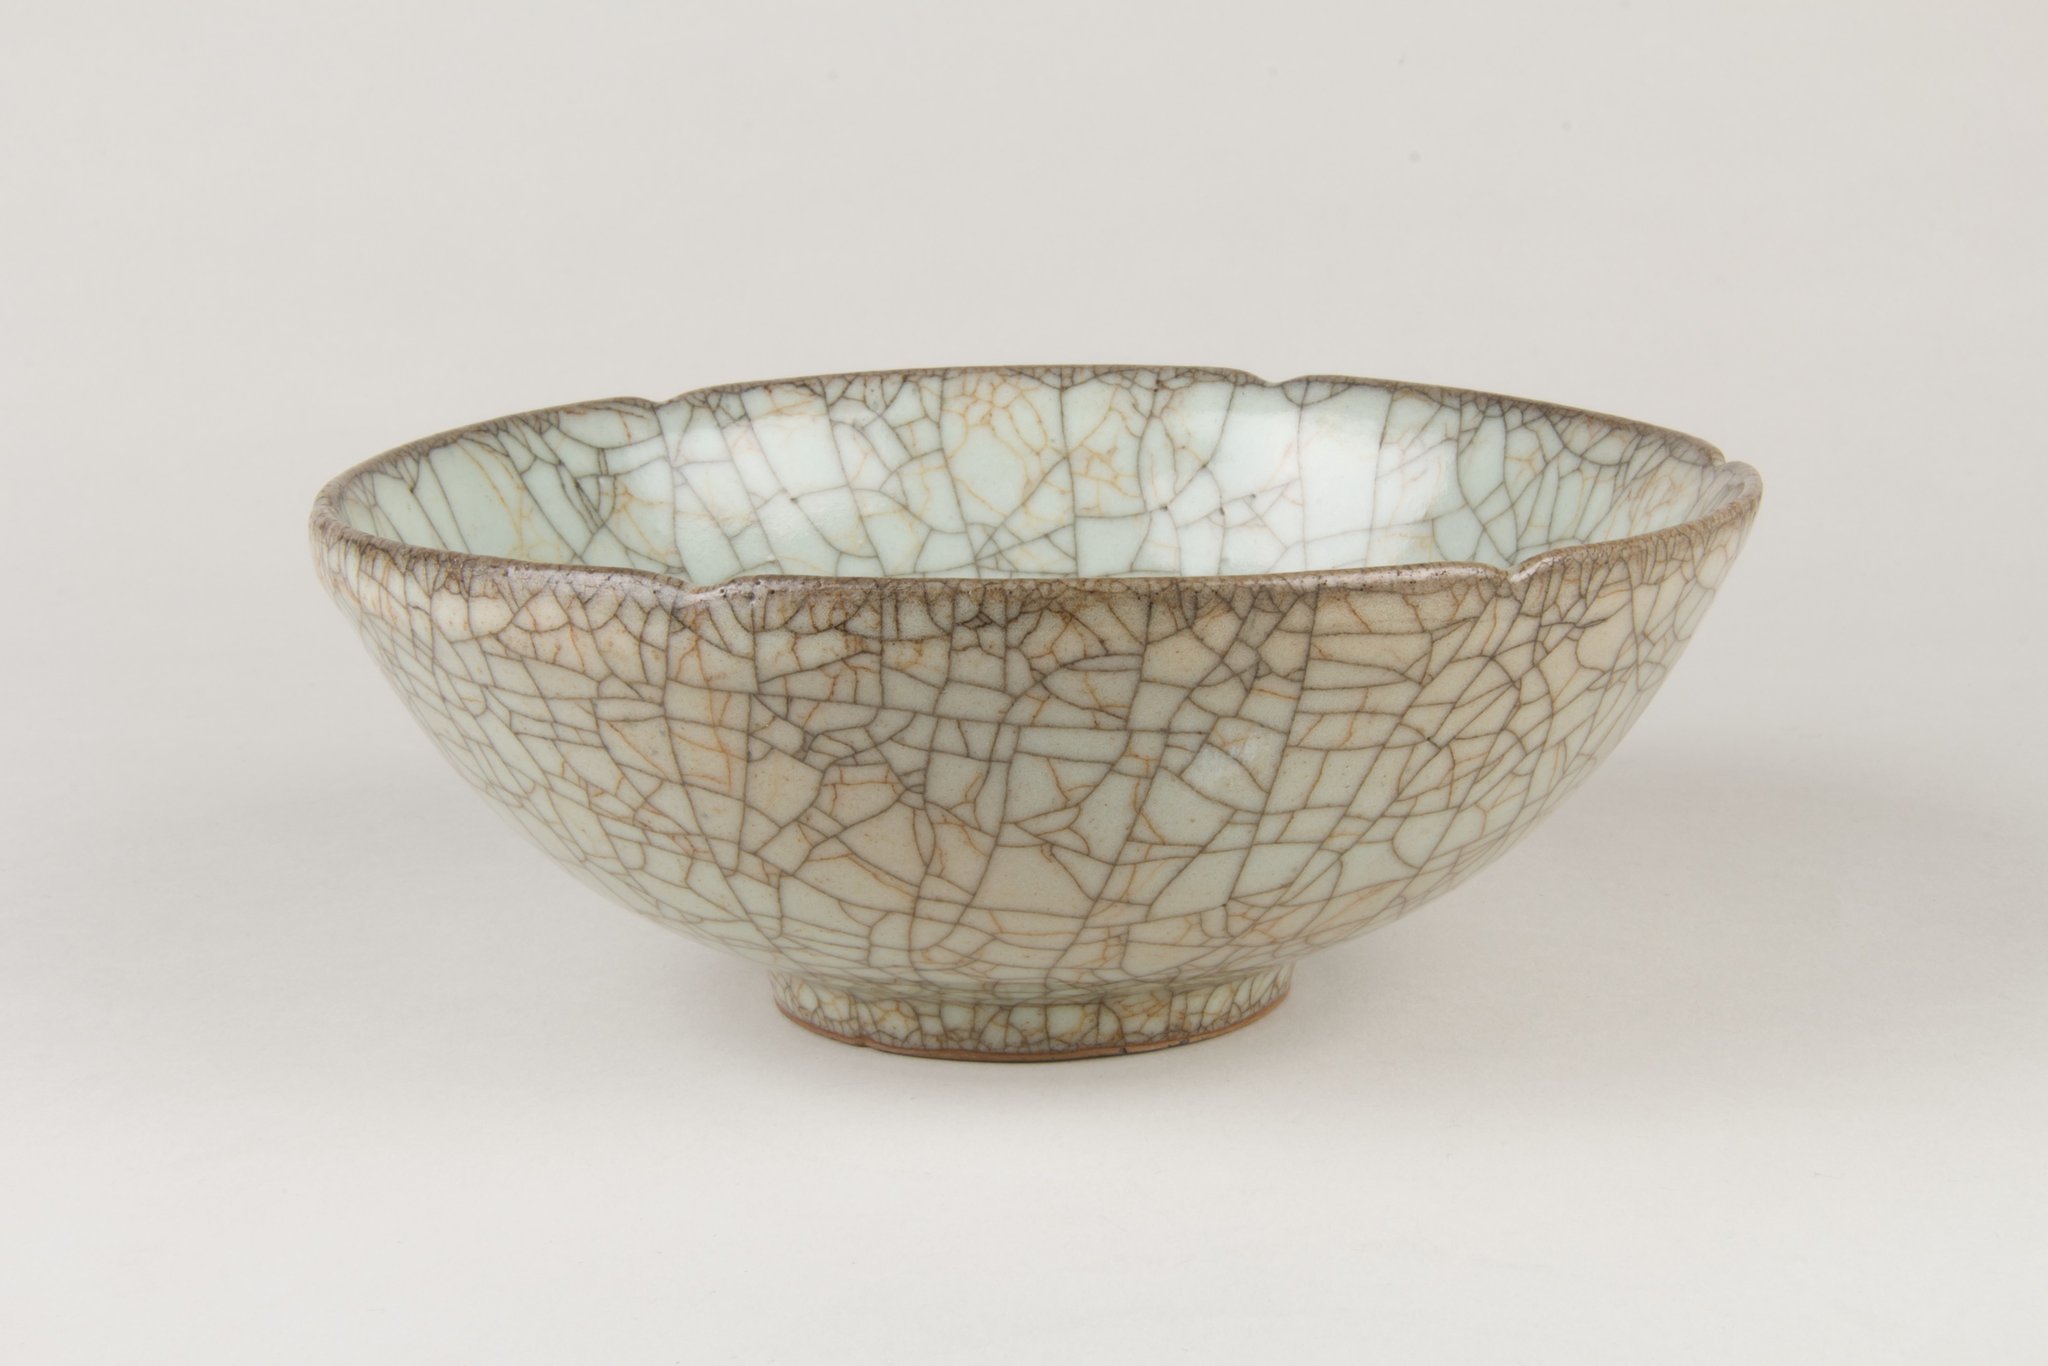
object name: bowl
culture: chinese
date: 960-1279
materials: pottery